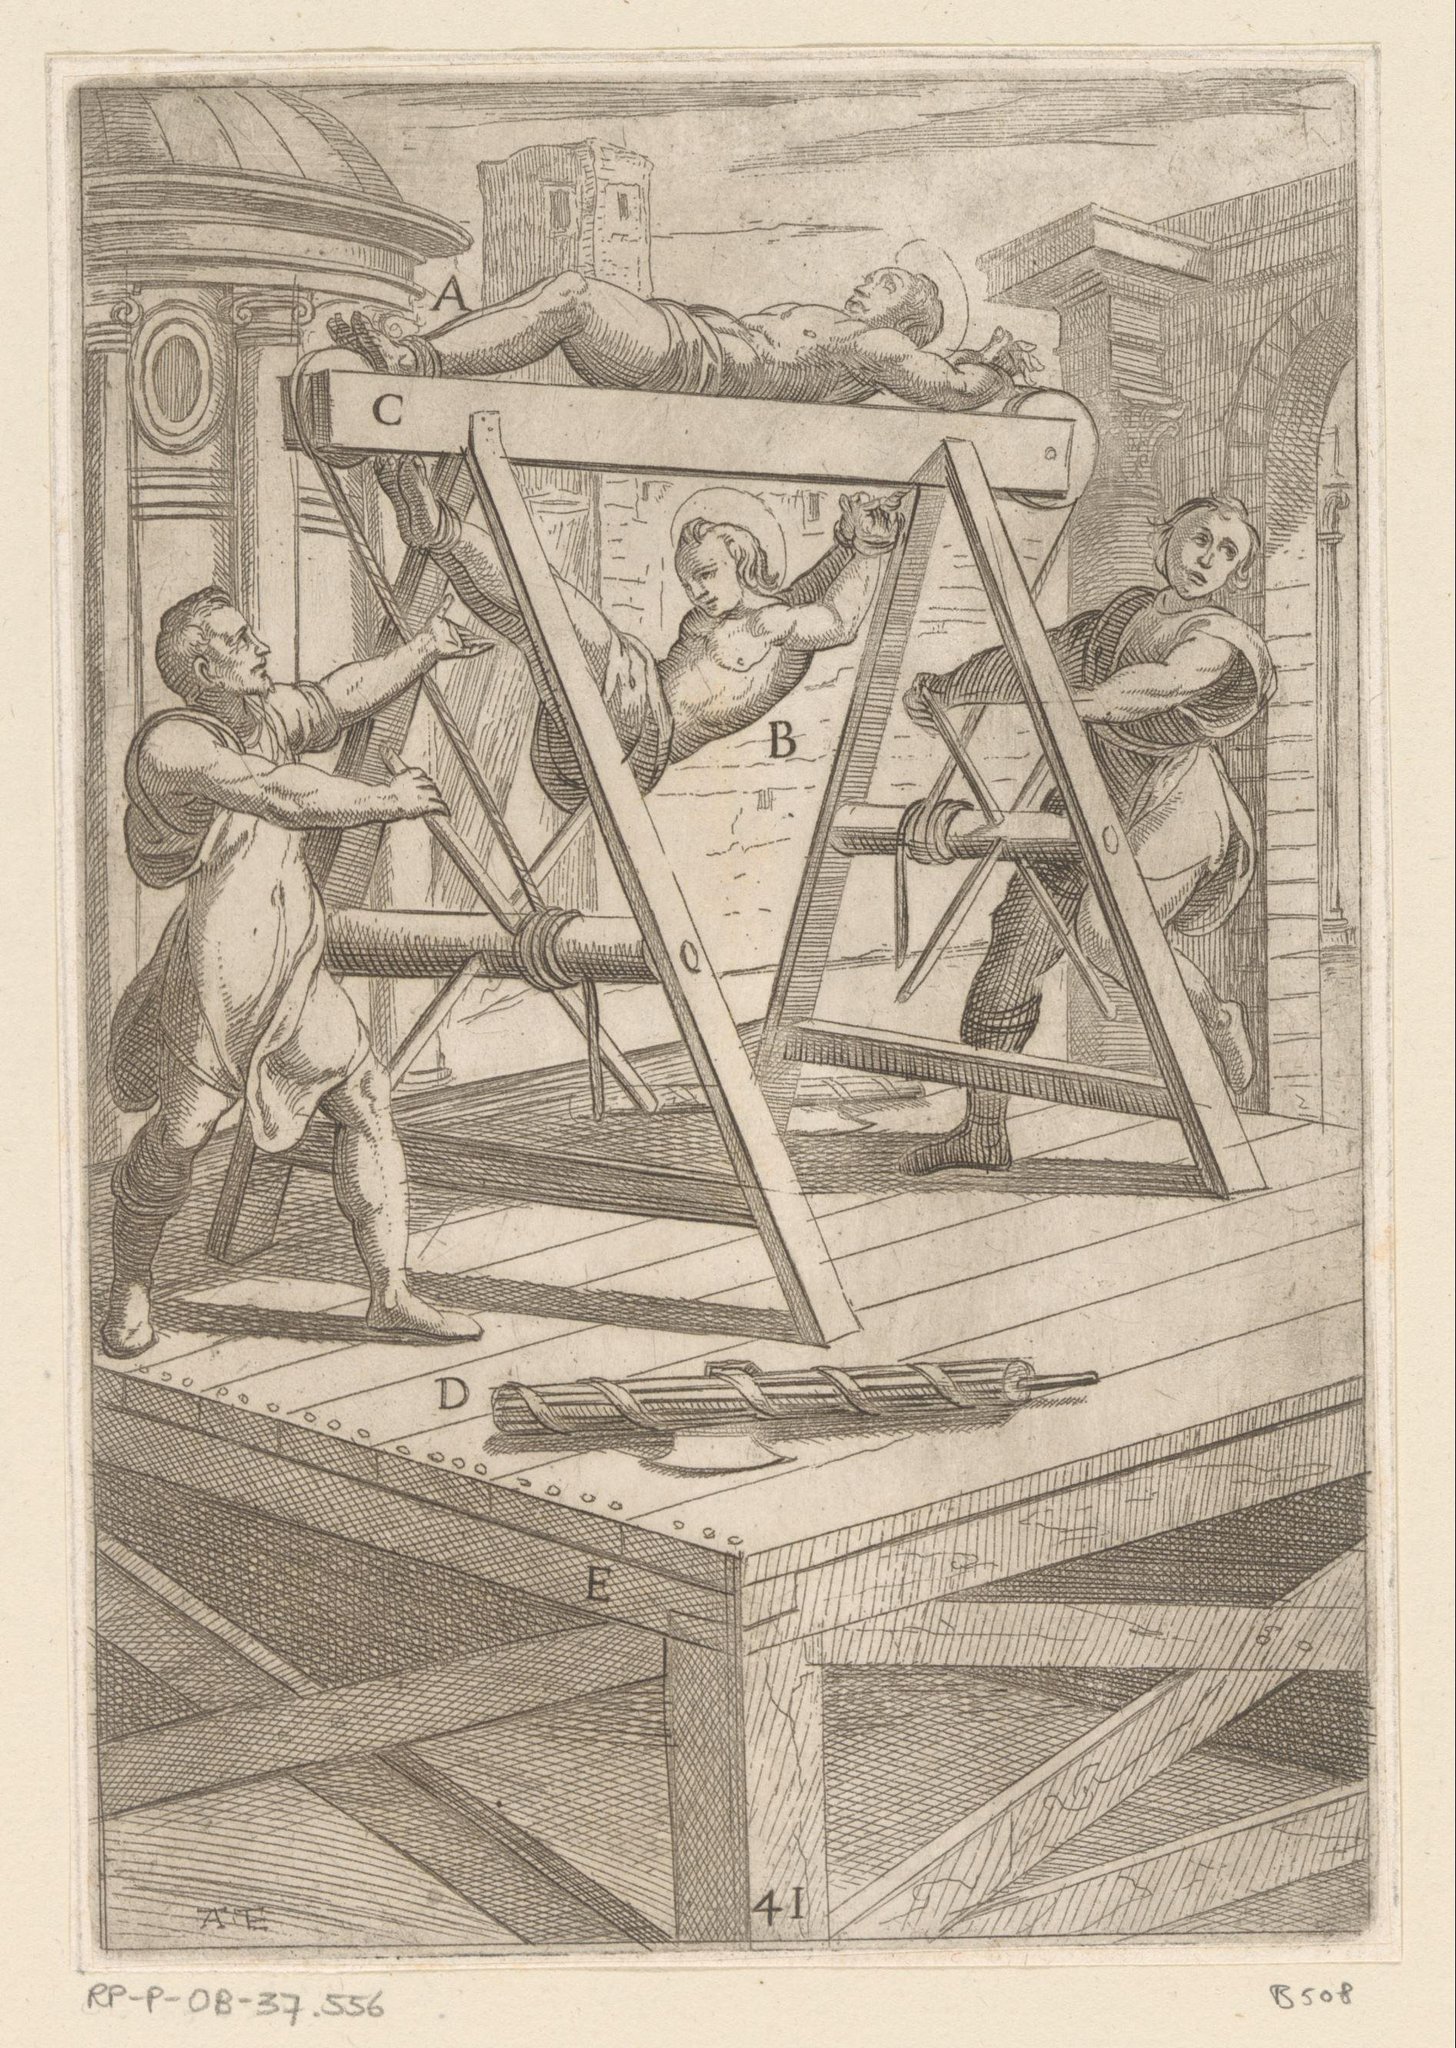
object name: print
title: Foltering: dubbele oprekking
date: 1565-1630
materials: paper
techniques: etching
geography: italy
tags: violent death ~ maltreatment, torture, torture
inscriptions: collector's mark: Lugt 240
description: Deze prent maakt deel uit van een reeks van 47 prenten (+ titelprent) met voorstellingen van martelmethoden. Deze prenten zijn in een andere editie gebruikt als illustraties voor Antonio Gallonio's 'Trattato degli Instrumenti di Martirio e delle Varie Maniere di Martoriare Usate dai Gentili contro Christiani' (Rome, Ascanio en Girolamo Dongangeli, 1591).